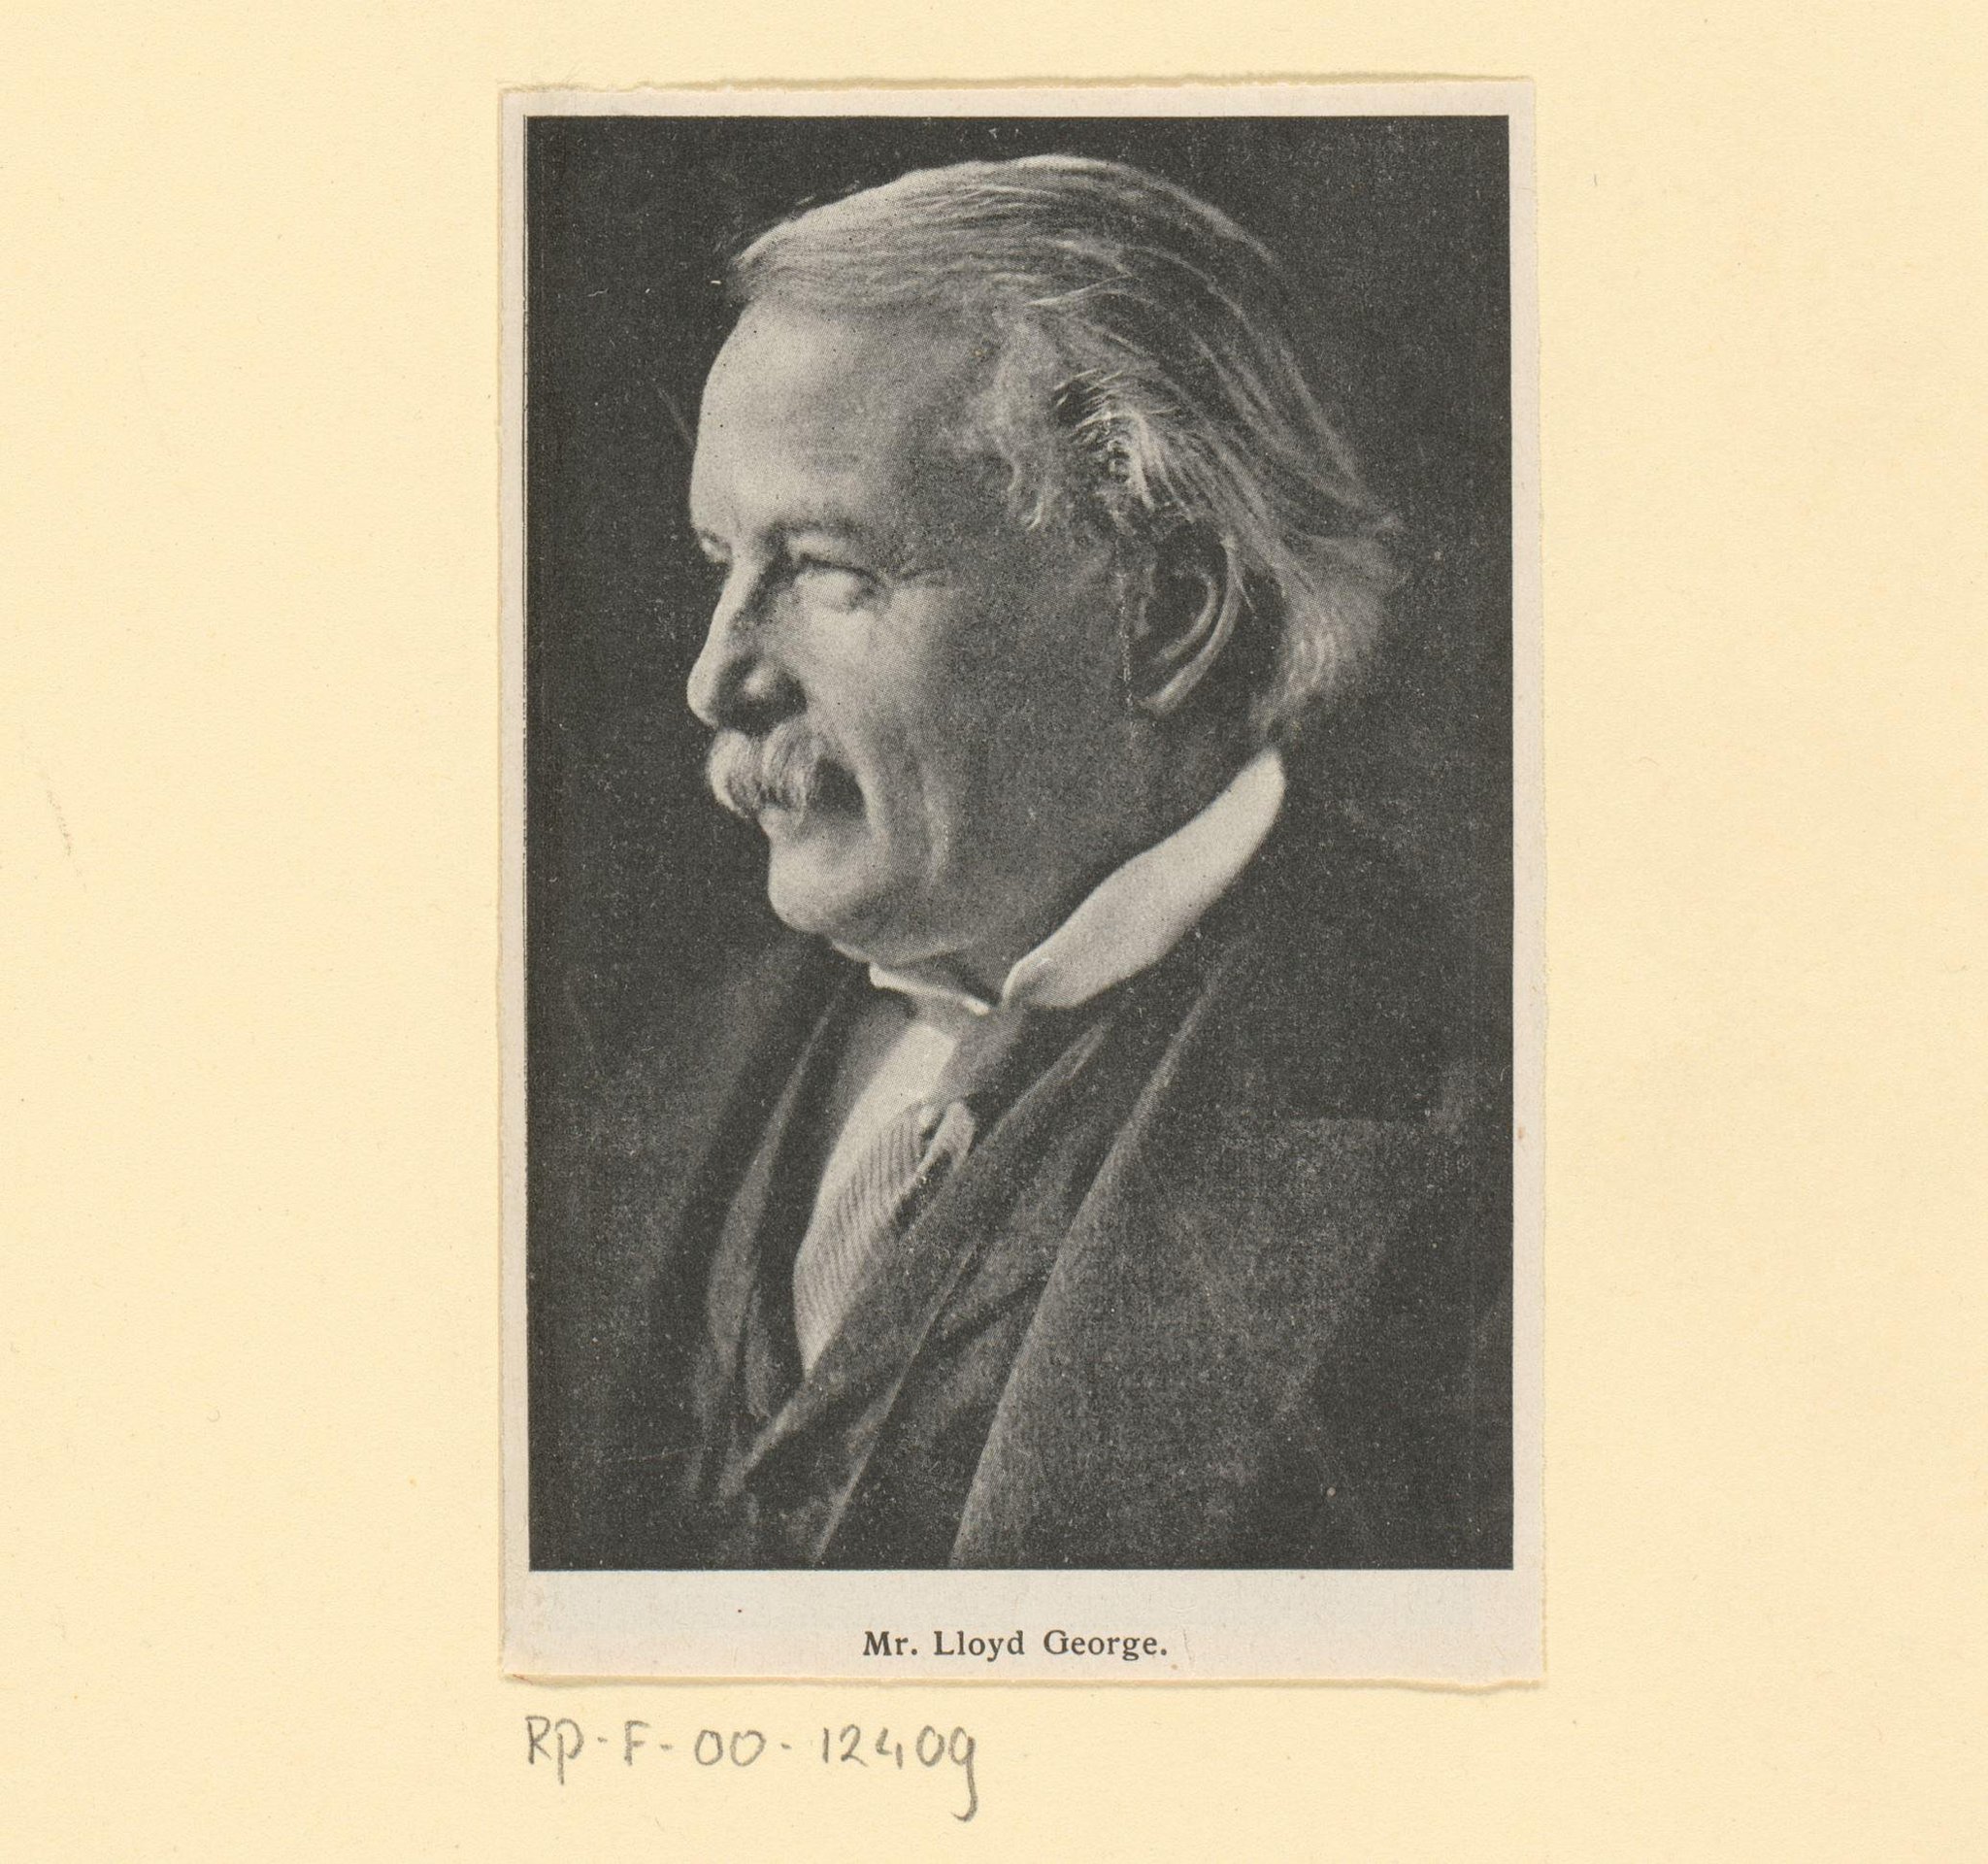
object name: photomechanical print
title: Portret van David Lloyd George, premier van het Verenigd Koninkrijk tussen 1916 en 1922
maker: Anonymous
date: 1916-1945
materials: paper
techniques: autotype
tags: historical persons, politician, e.g. party leader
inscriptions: inscription: ‘Mr. Lloyd George’